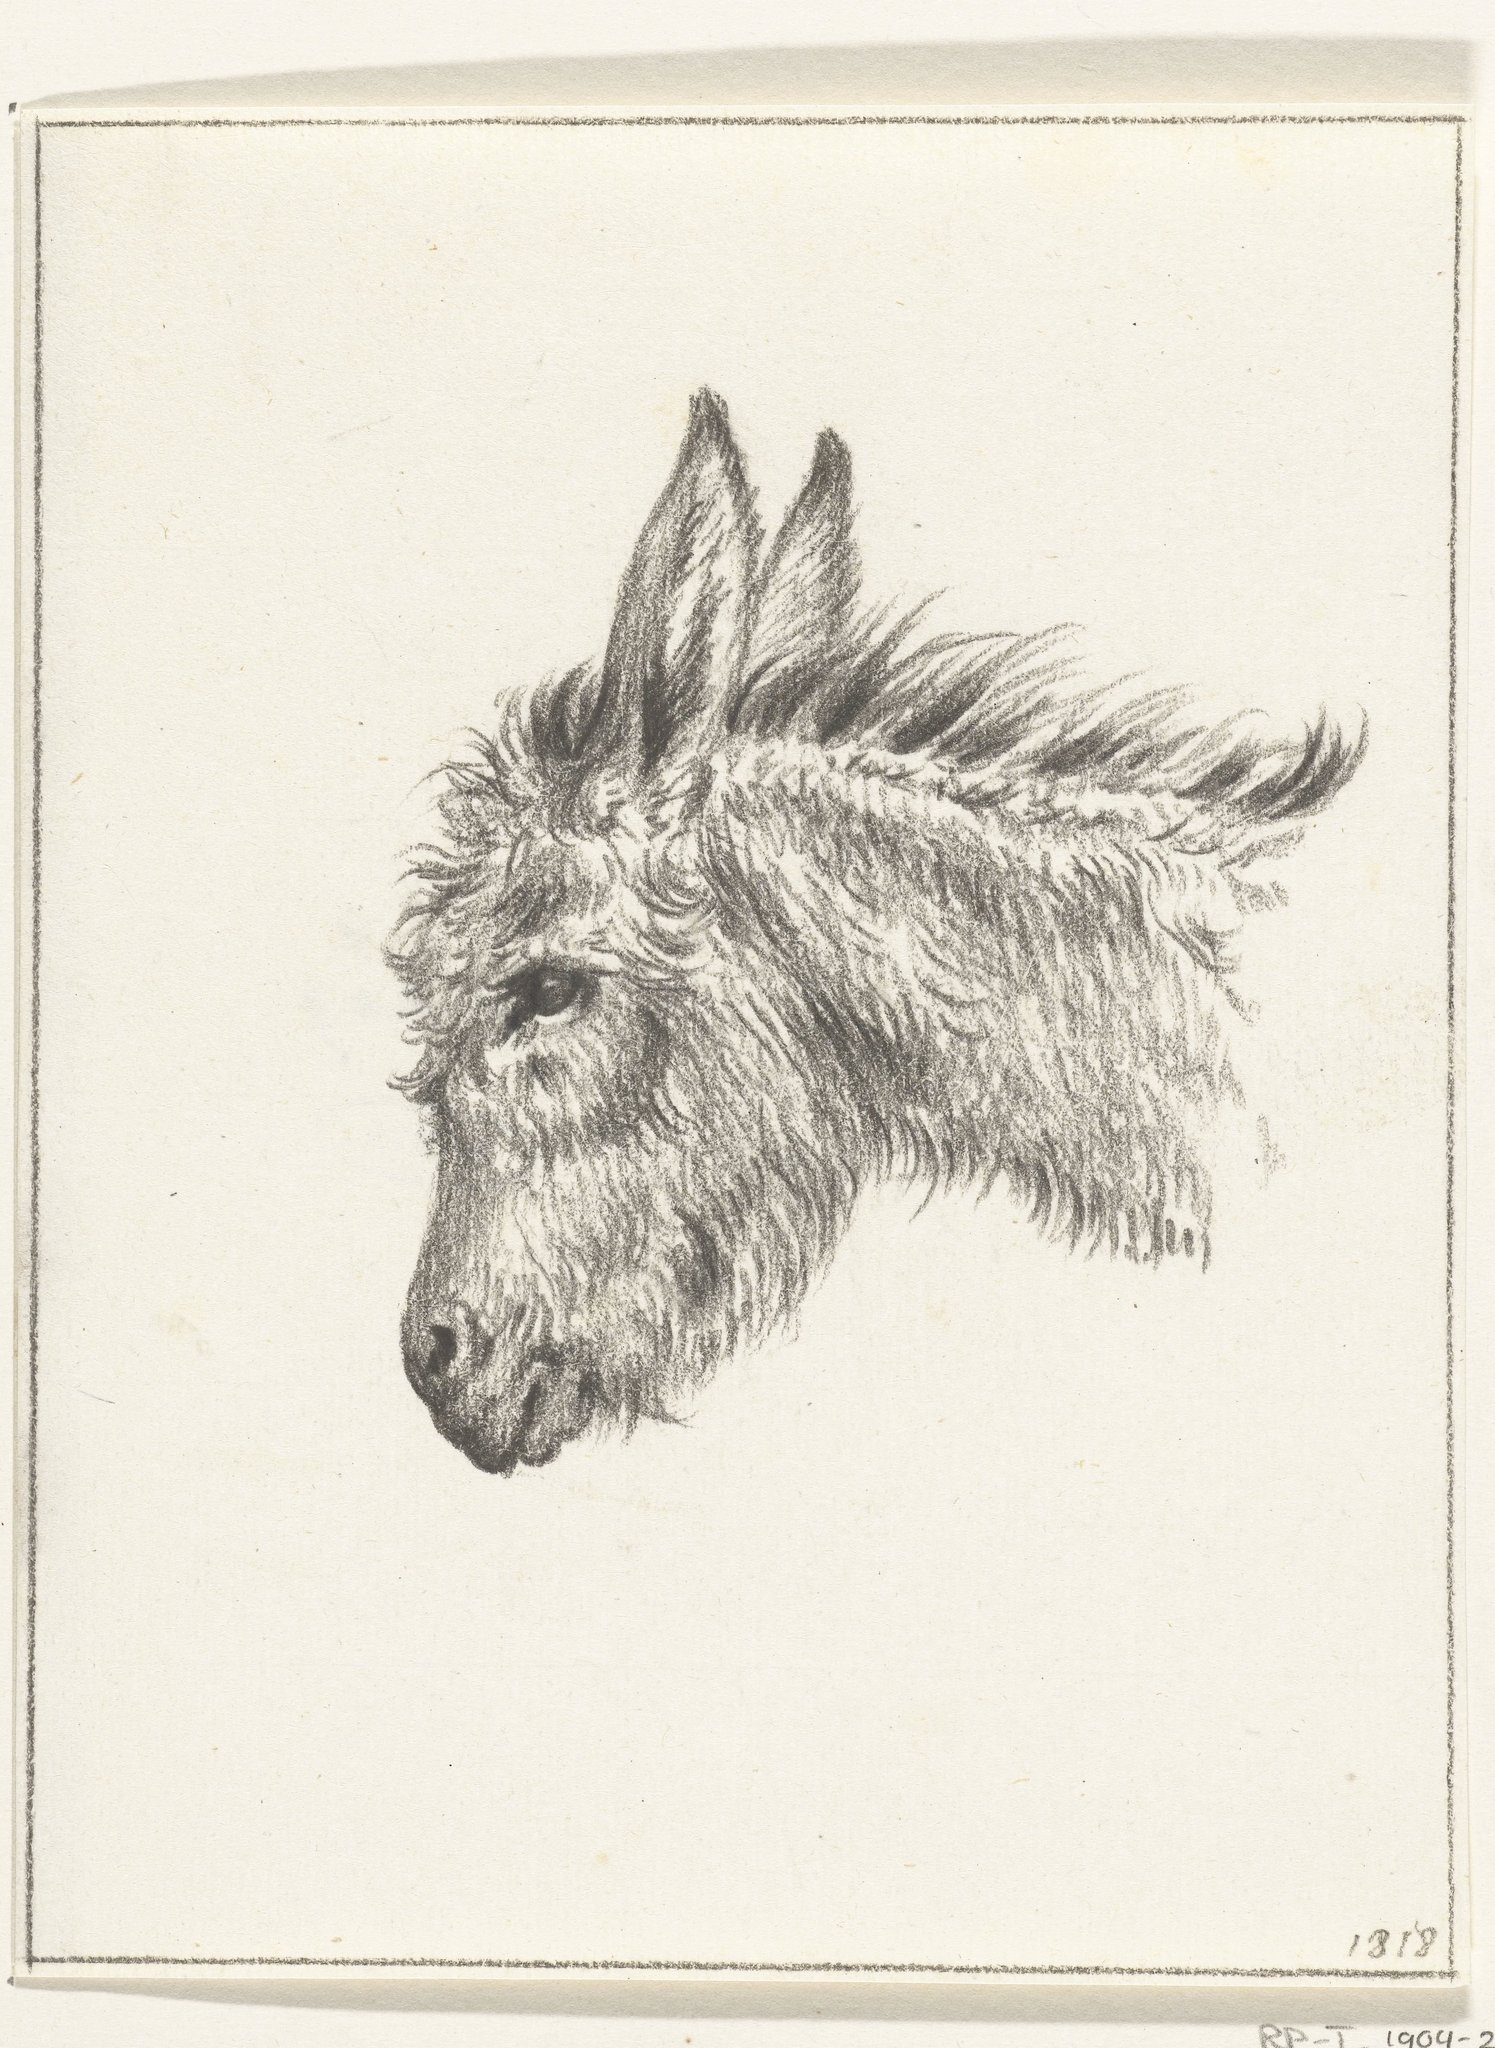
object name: drawing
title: Kop van een ezel, naar links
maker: jean bernard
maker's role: draughtsman, print maker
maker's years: 1765-1833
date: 1818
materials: chalk, paper, pencil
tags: ass, donkey